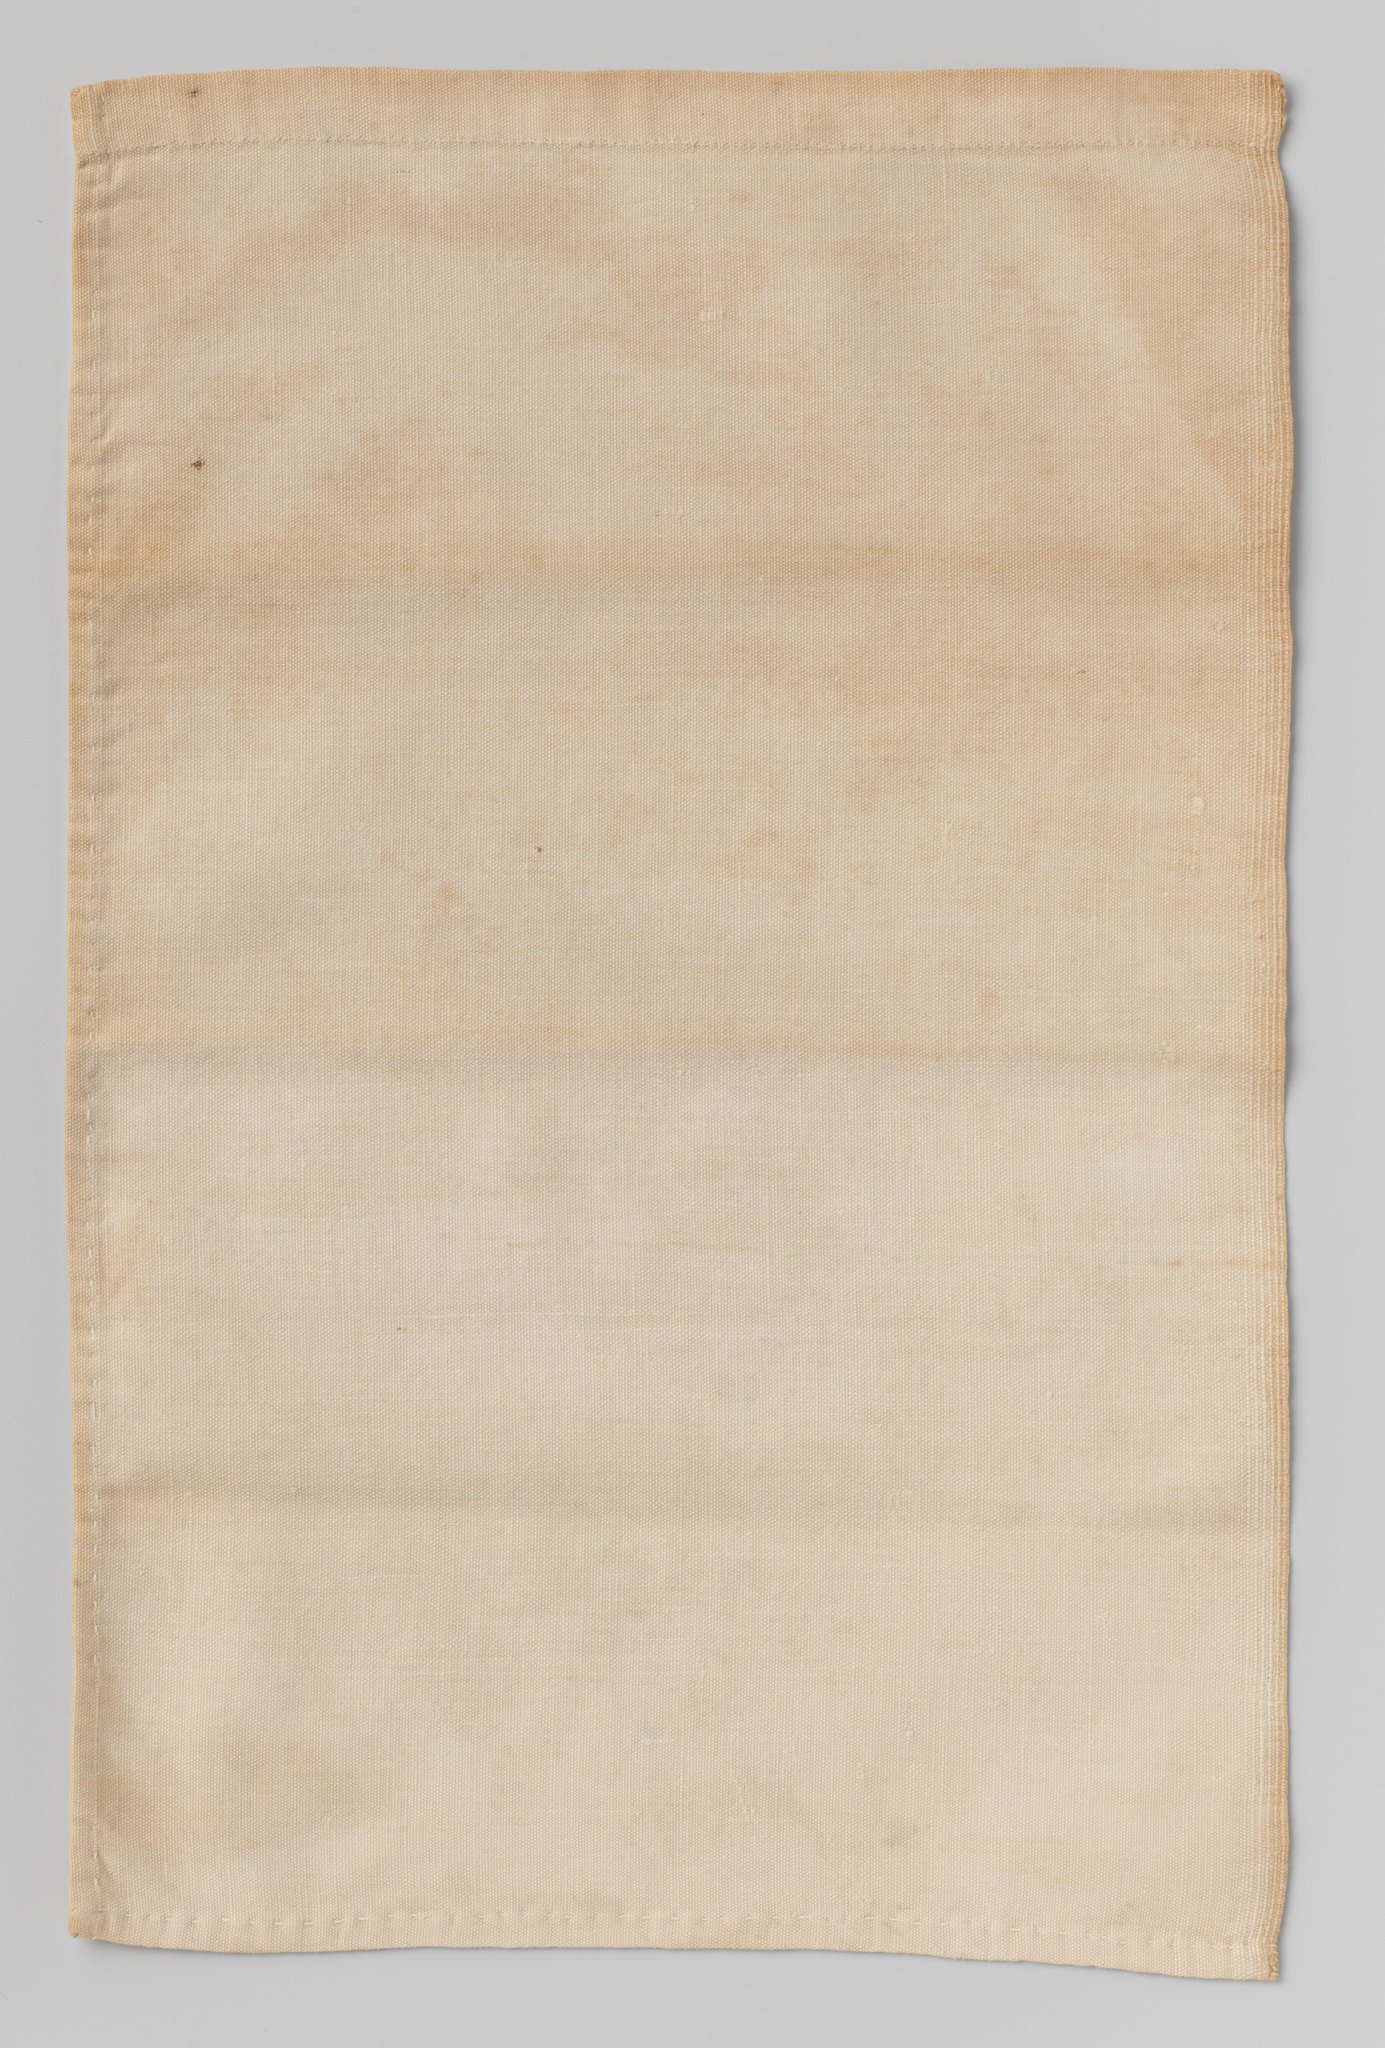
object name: beddenlaken, laken object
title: Laken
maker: Anonymous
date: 1750-1850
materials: linen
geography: netherlands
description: Een grof linnen laken, aan twee zijden omzoomd met smalle zoom; bovenzijde met brede zoom, één zelfkant.